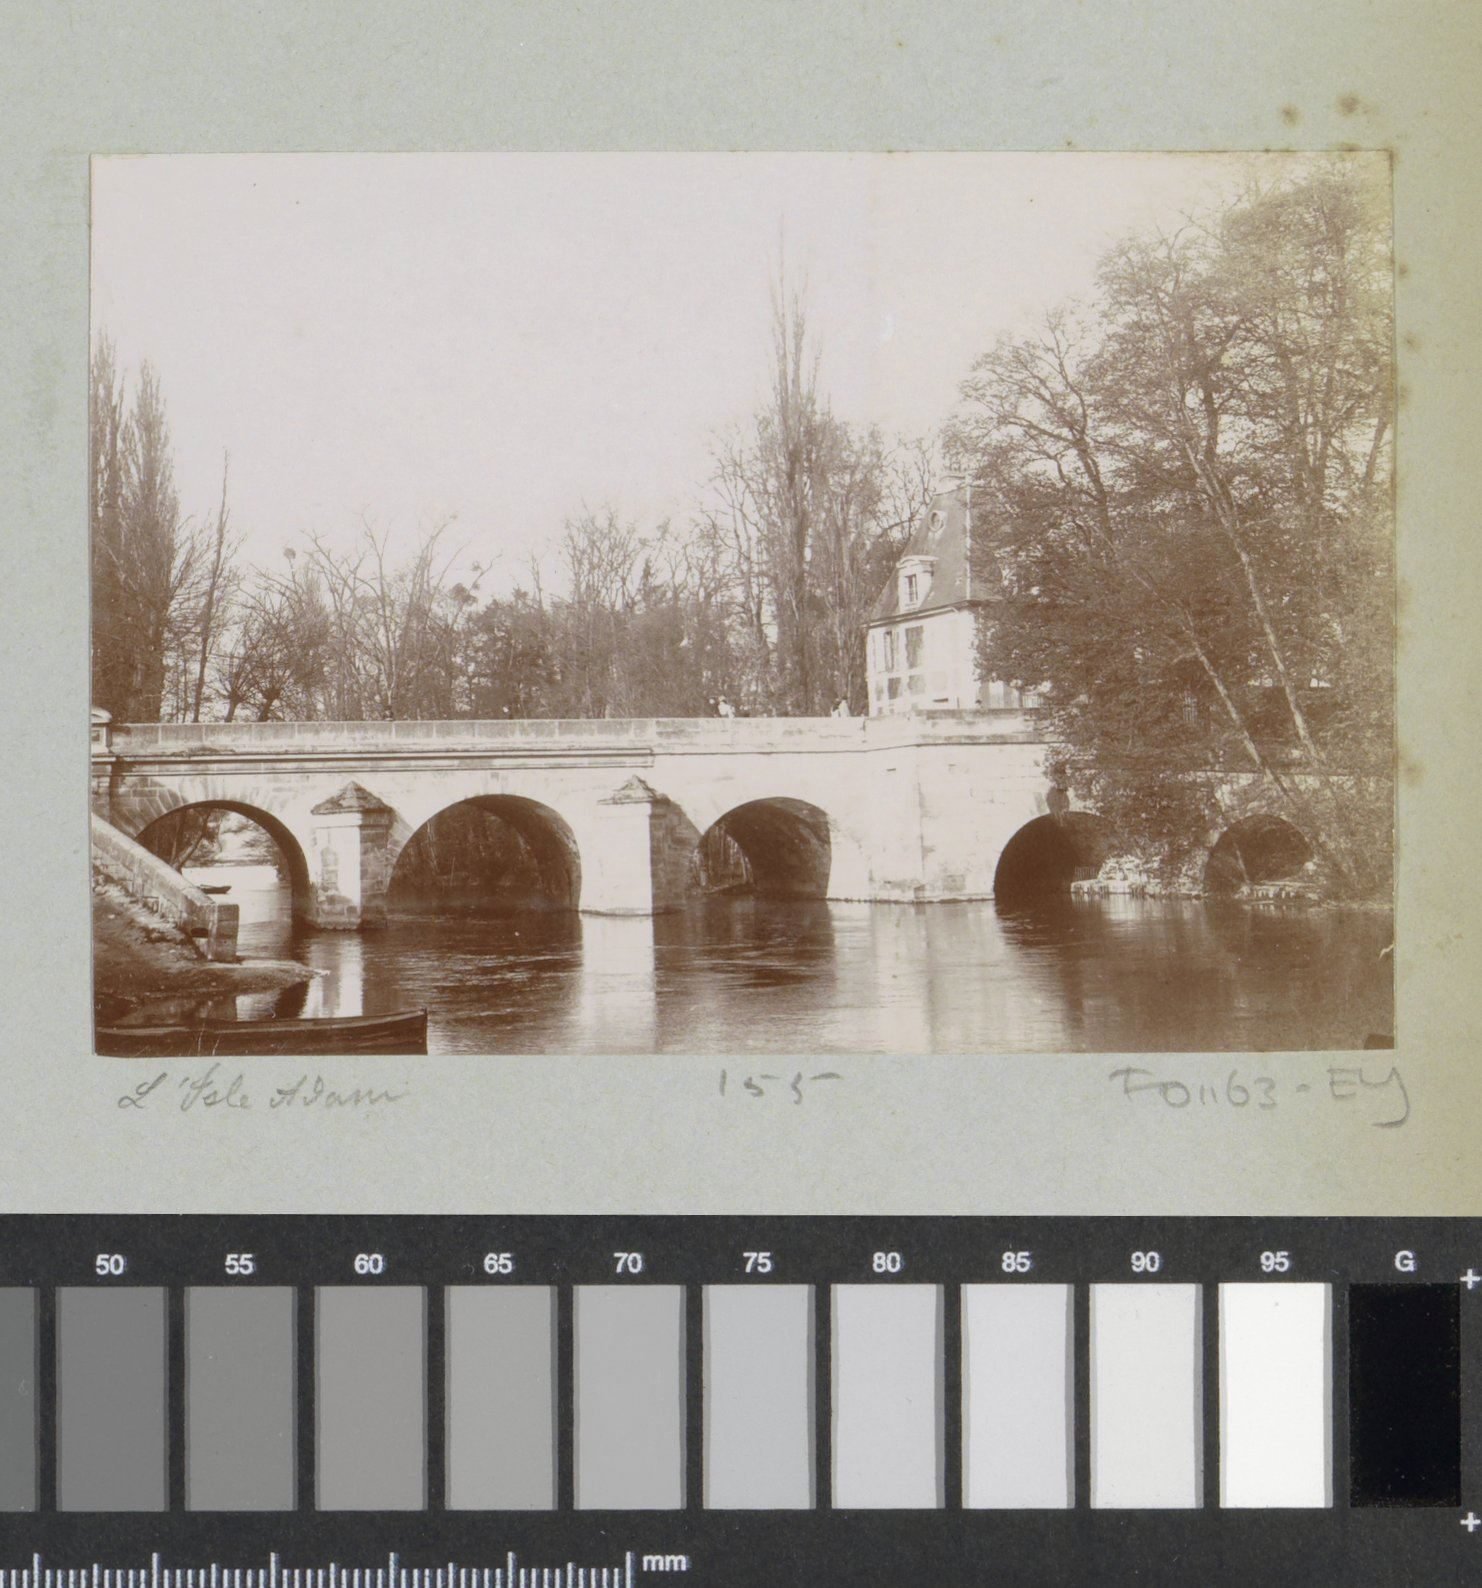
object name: photograph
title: Gezicht op de Pont du Cabouillet in L'Isle-Adam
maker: delizy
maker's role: manufacturer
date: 1897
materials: paper, photographic support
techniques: gelatin silver print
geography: l'isle-adam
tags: prospect of village, silhouette of village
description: Onderdeel van Fotoalbum van een Franse amateurfotograaf met opnames van uitstapjes in Frankrijk, Spanje, België, Luxemburg en Nederland, de eerste automobielen en autoraces.